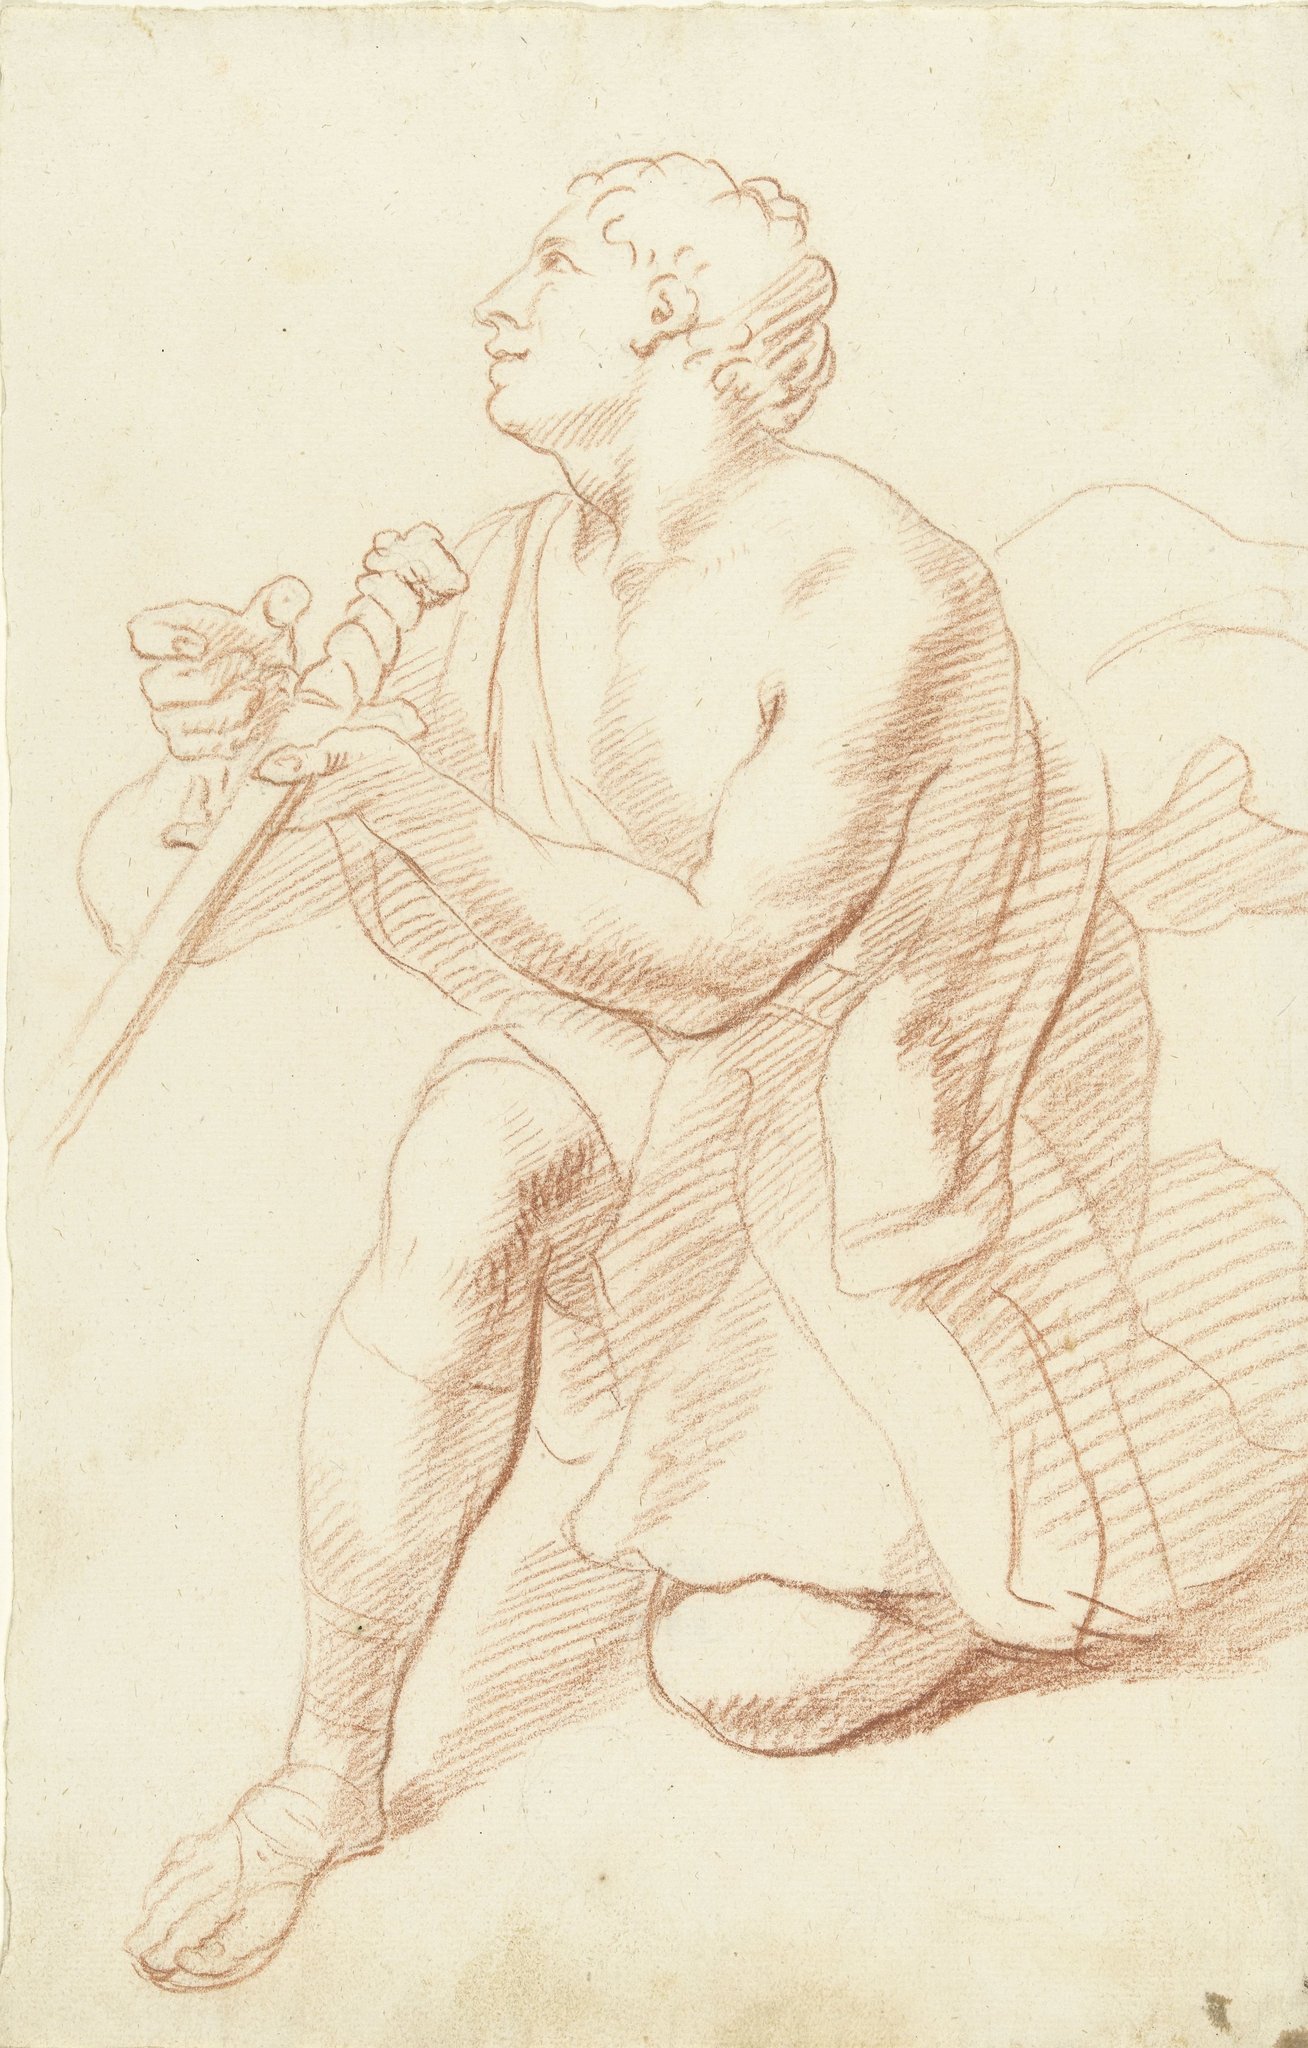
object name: drawing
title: Studie van een knielende man met zwaard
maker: dionys van nijmegen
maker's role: draughtsman, painter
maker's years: 1705-1798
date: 1715-1798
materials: chalk, paper